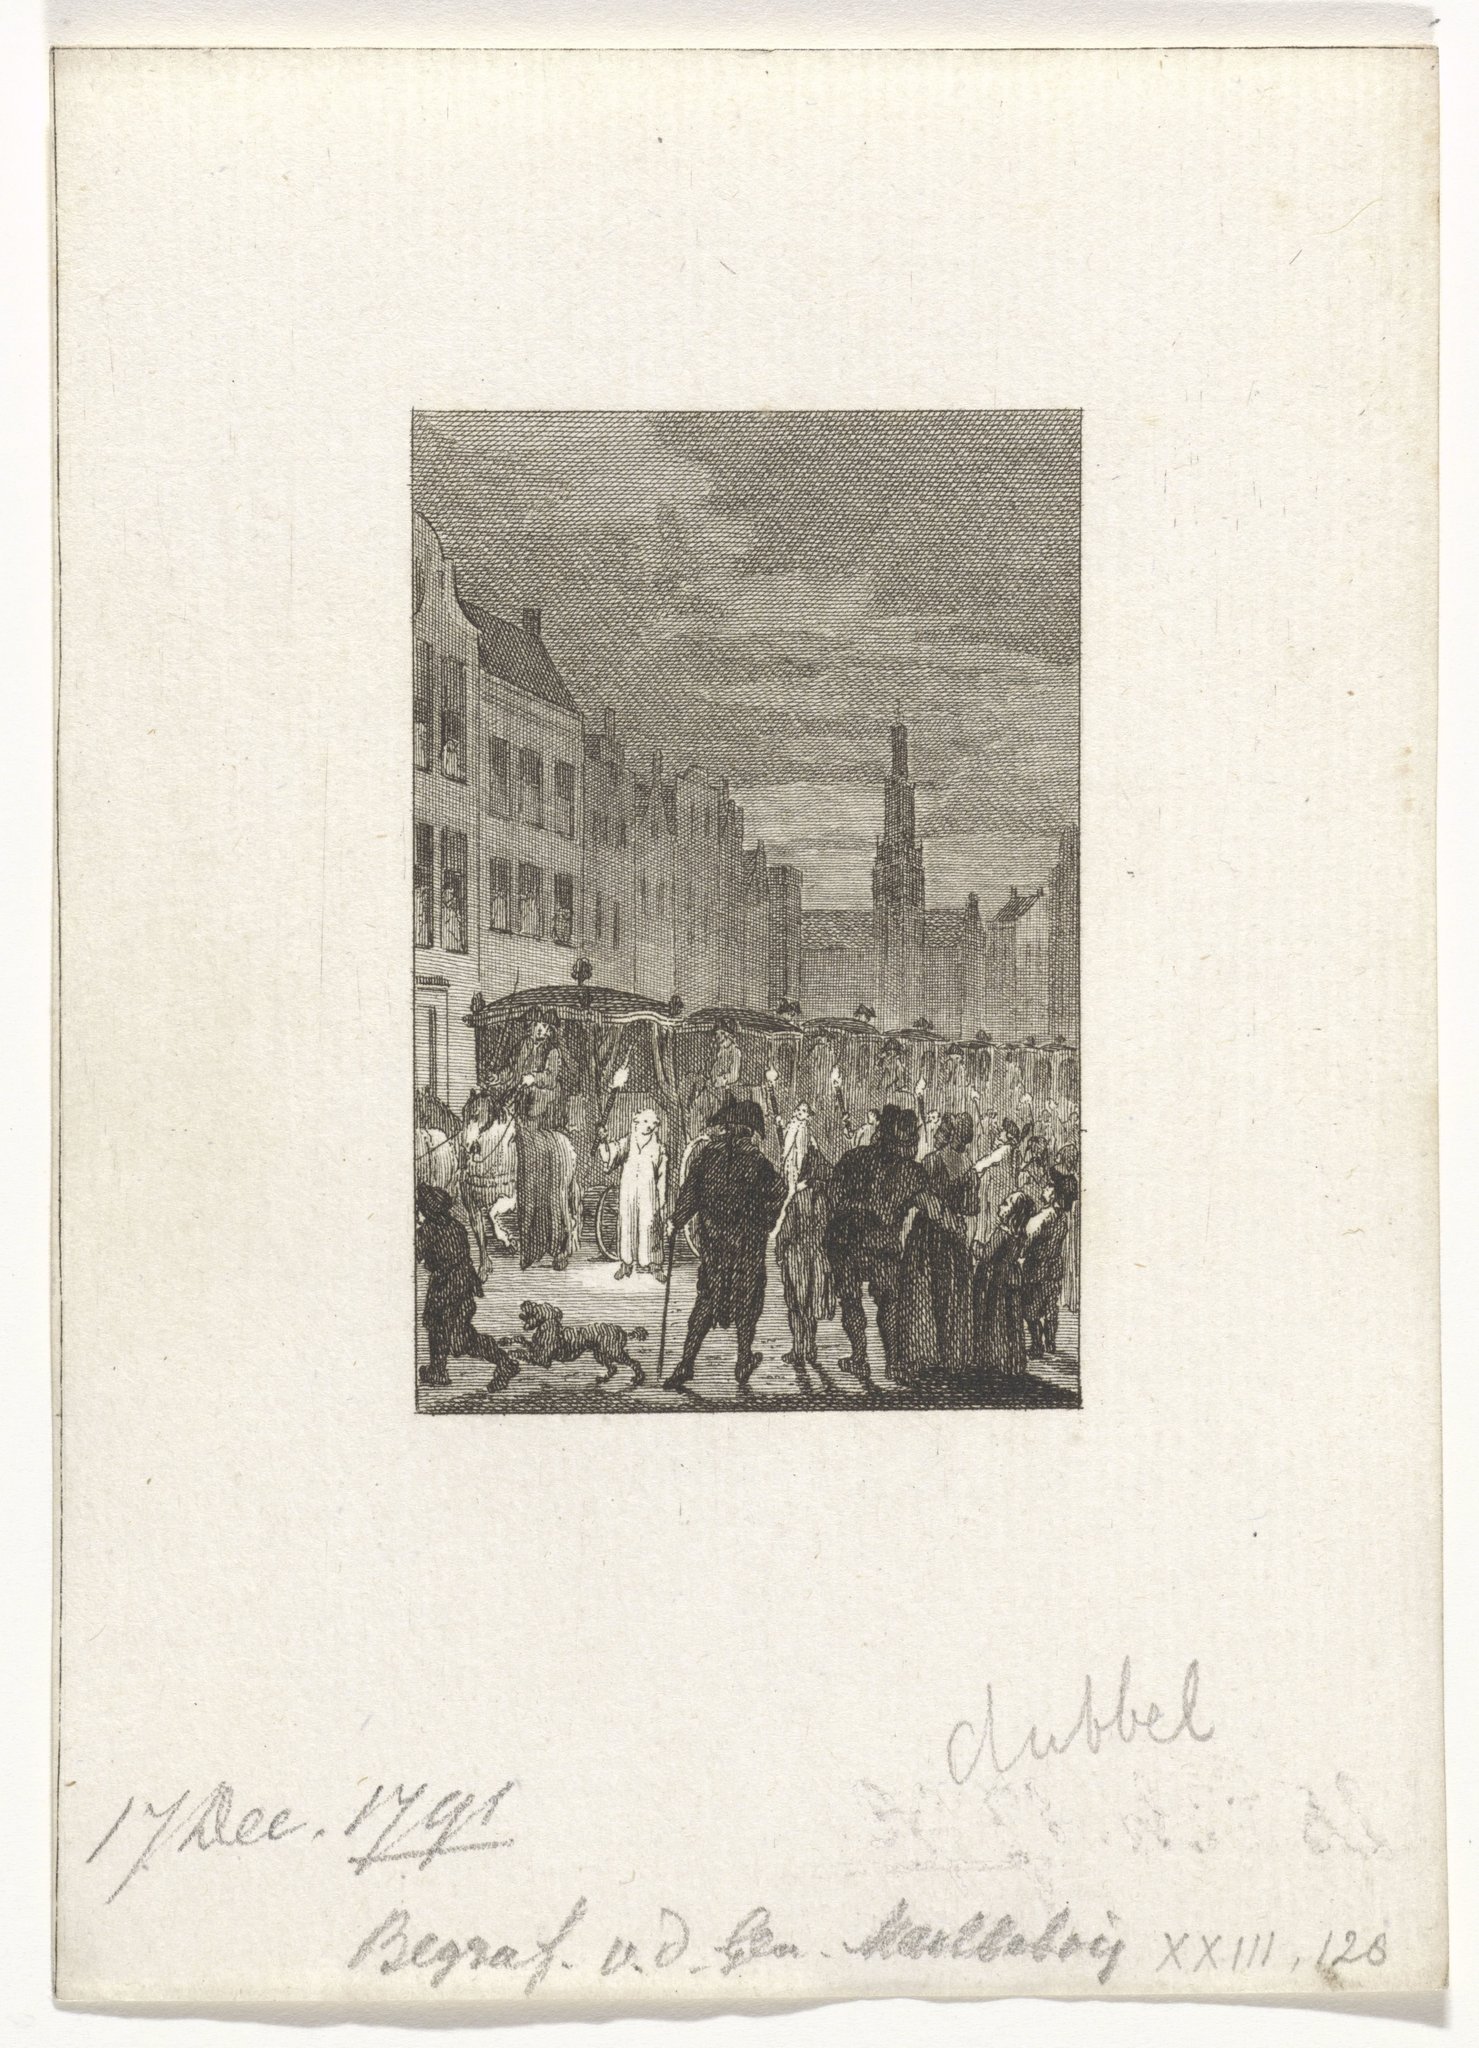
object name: history print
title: Begrafenis van de Franse graaf de Maillebois te Maastricht, 1791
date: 1783-1795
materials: paper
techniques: etching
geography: amsterdam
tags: cortege, funeral procession, maastricht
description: Begrafenis van de Franse graaf de Maillebois te Maastricht, 17 december 1791. Begrafenisoptocht met stoet van rijtuigen begeleid door pages te voet met fakkels.